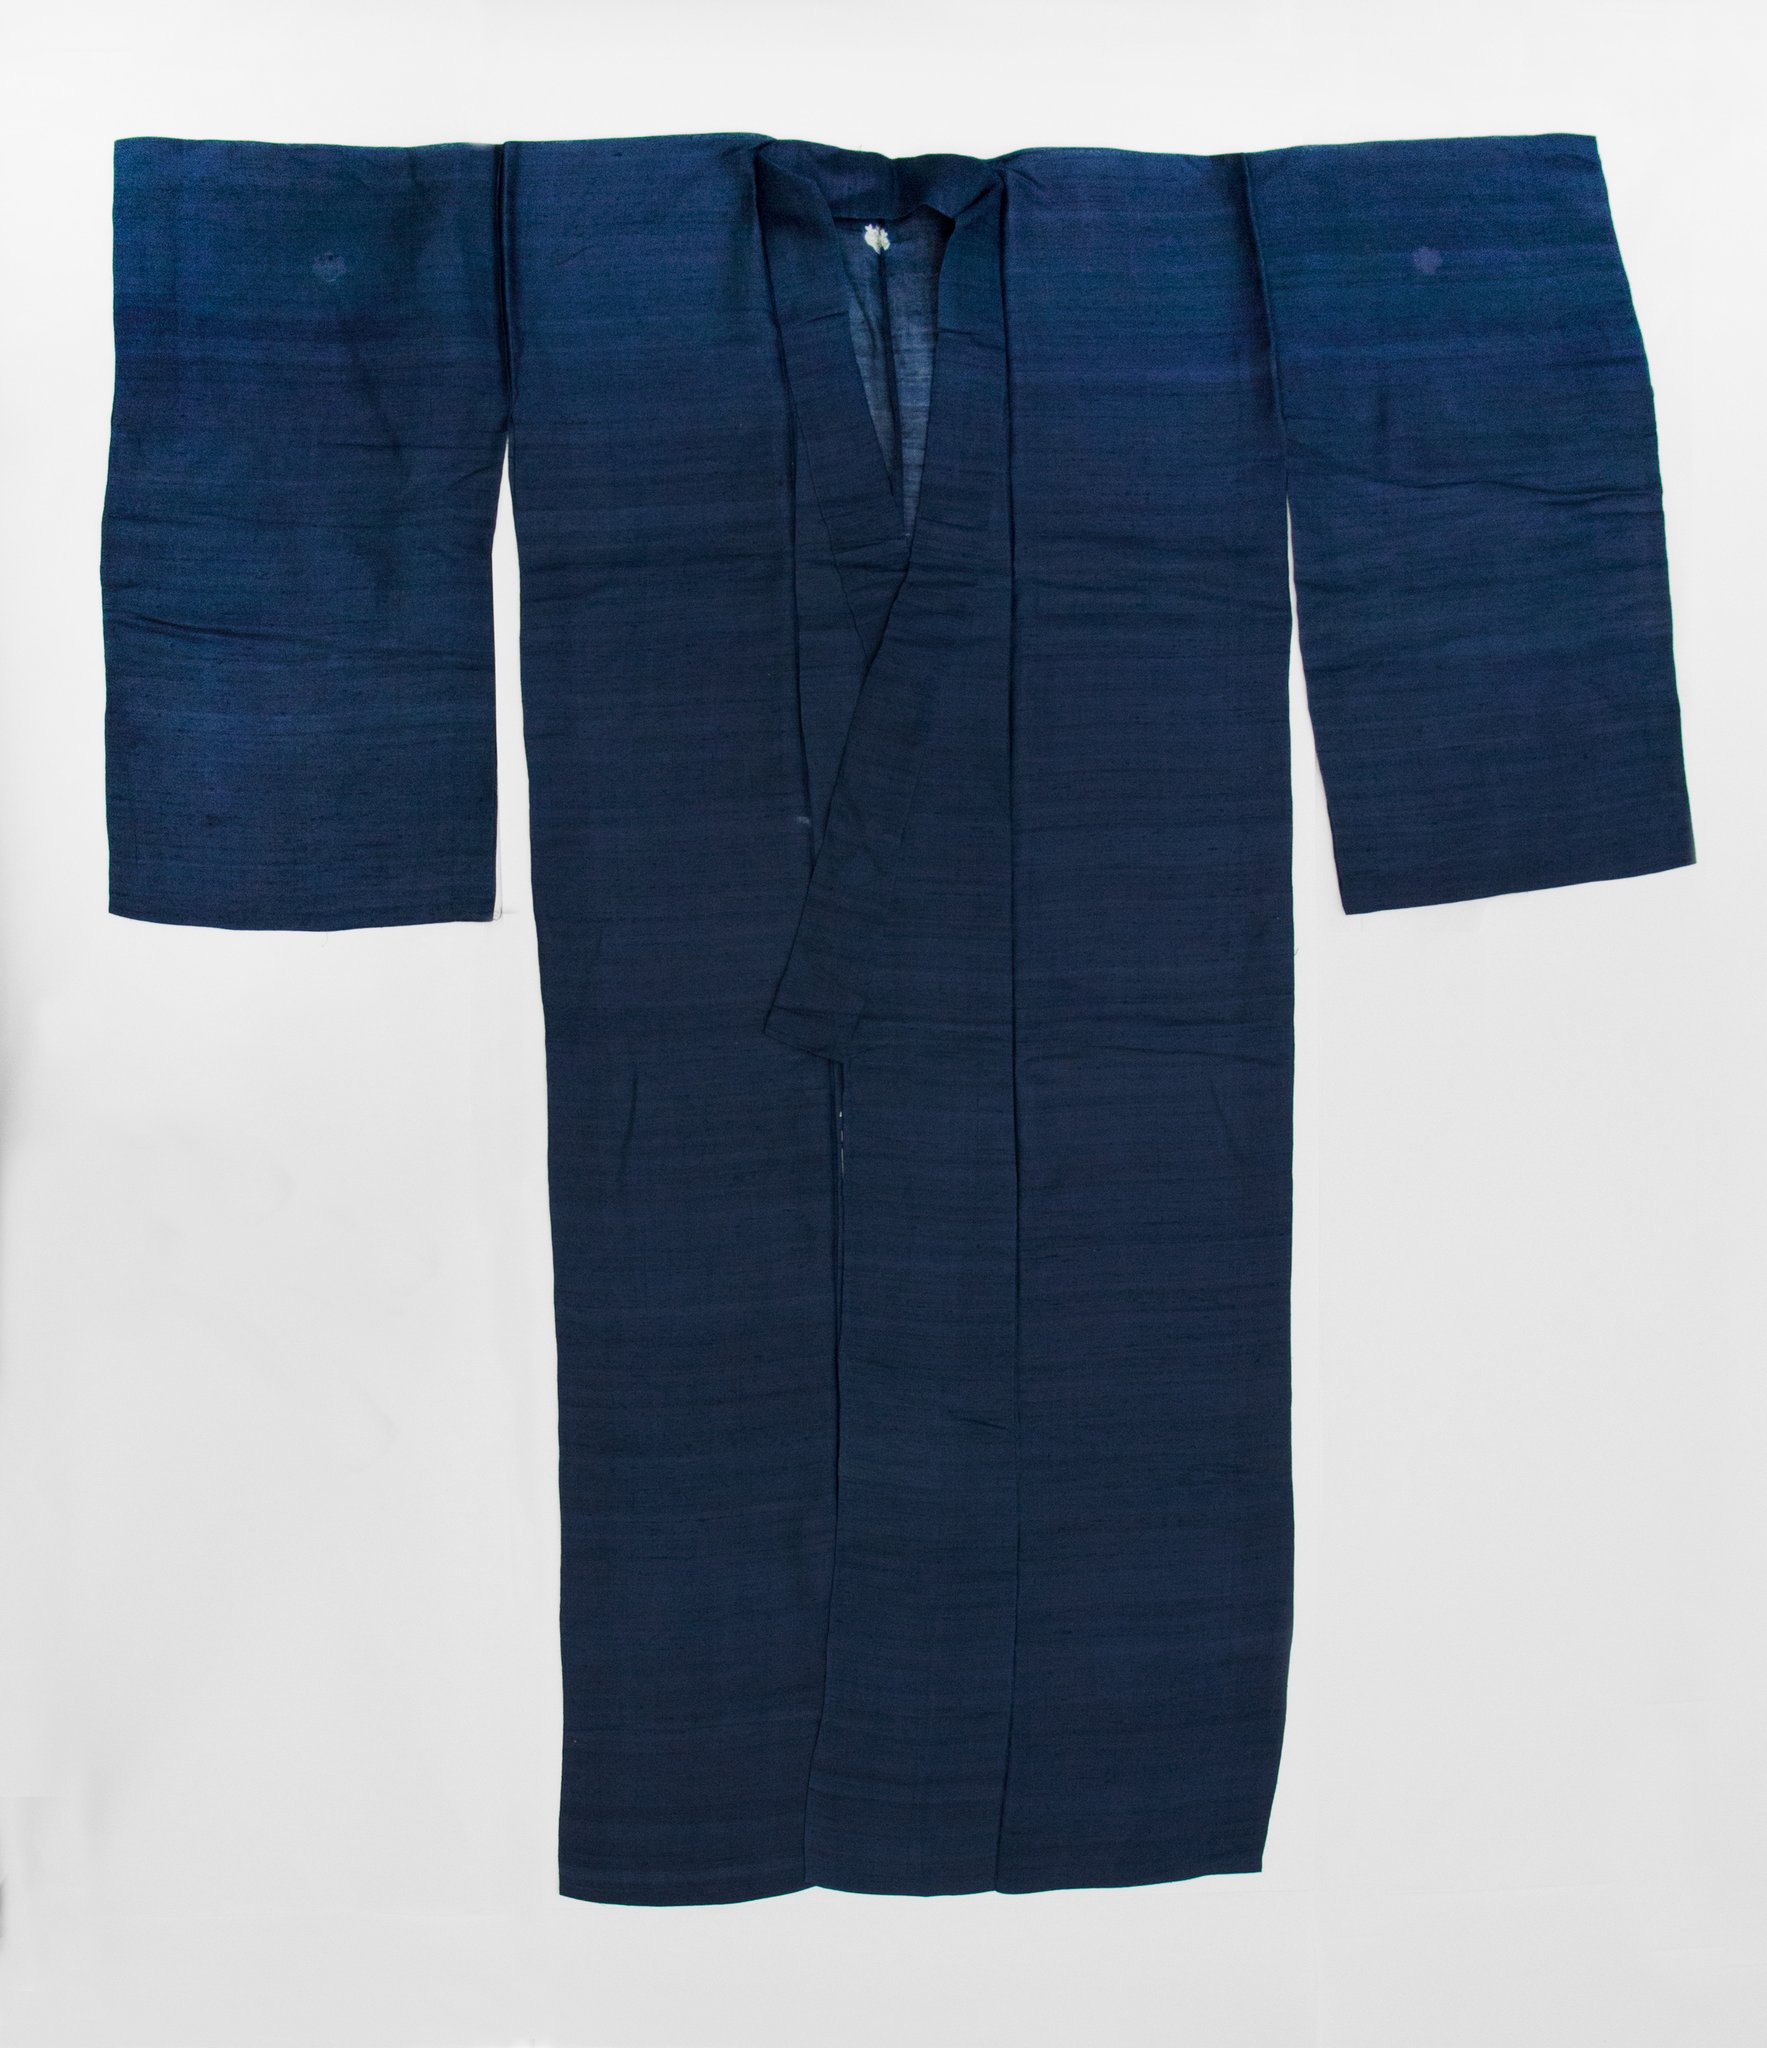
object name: kosode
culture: japanese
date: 1615-1868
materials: silk